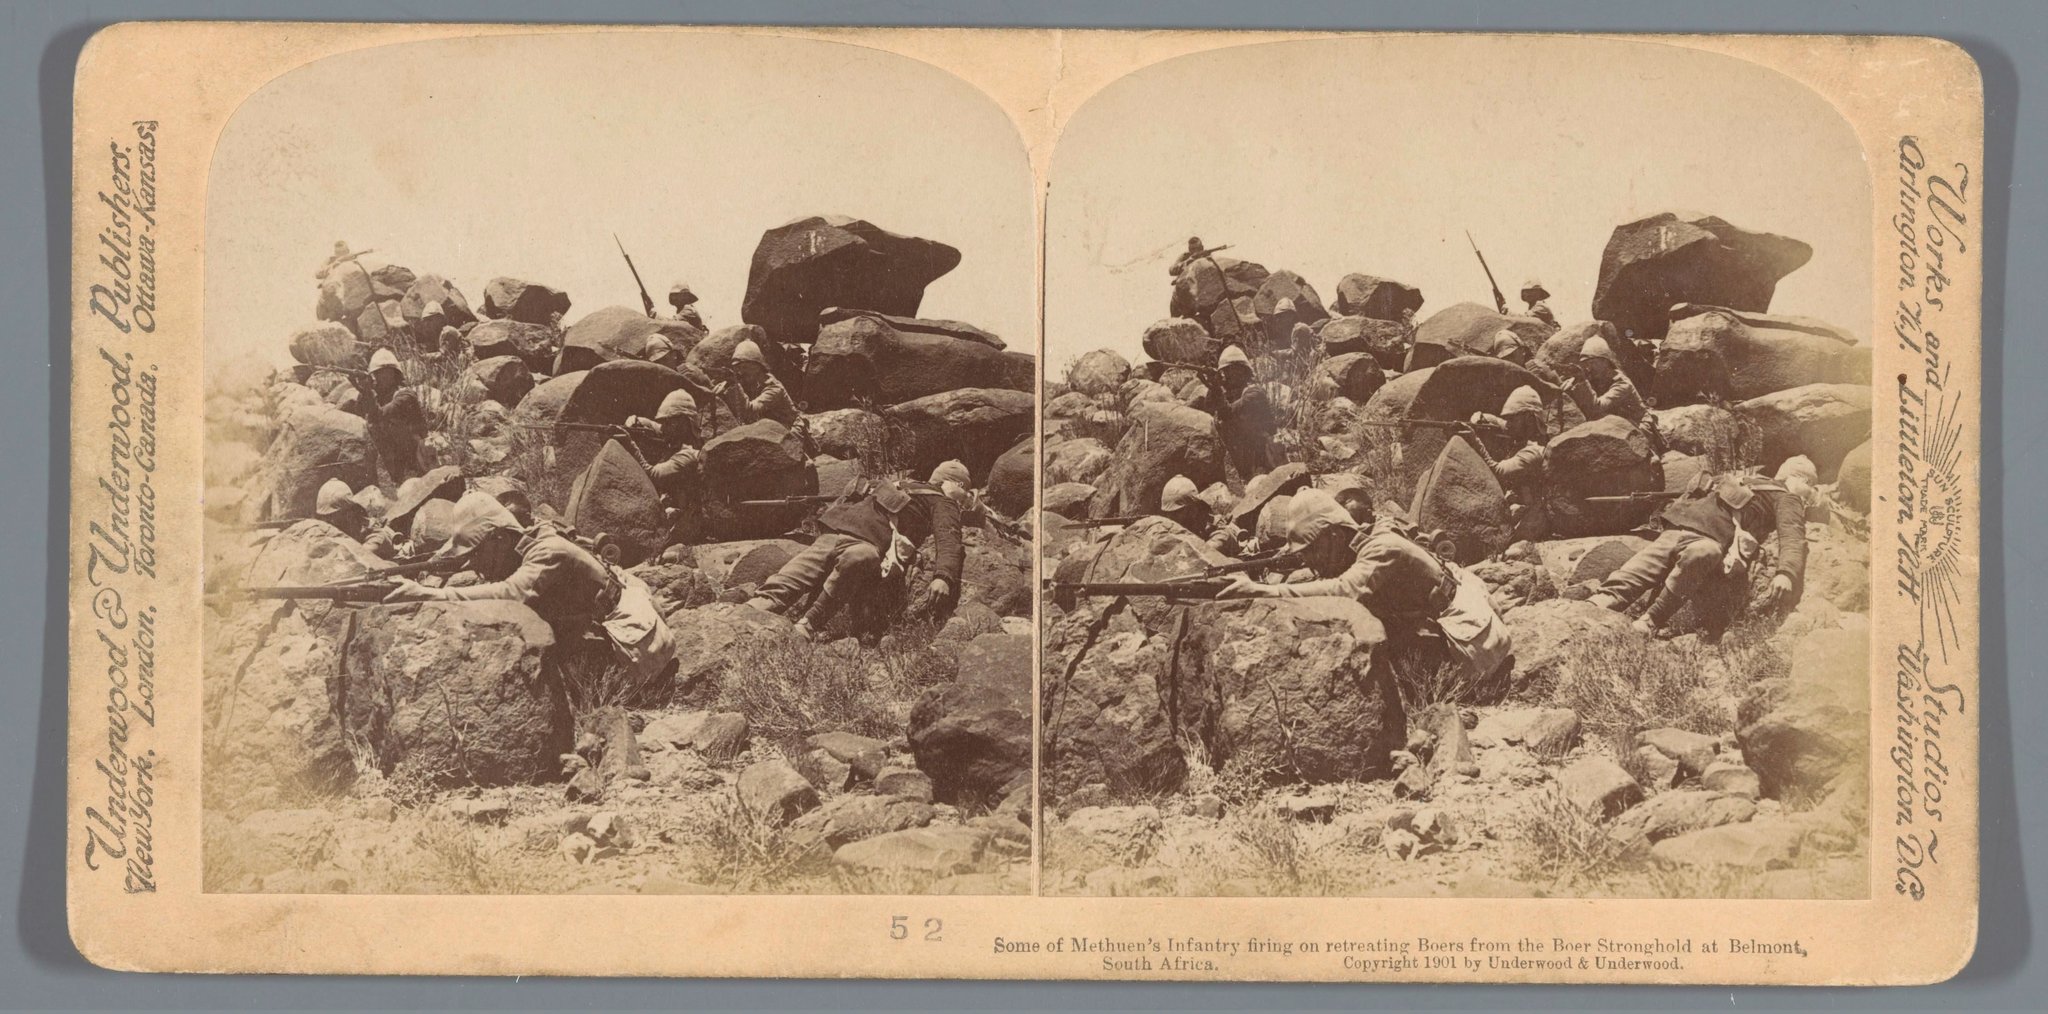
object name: stereograph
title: Some of Methuen's Infantry firing on retreating Boers, from the Boer Stronghold at Belmont, S.A.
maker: Anonymous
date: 1901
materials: cardboard, paper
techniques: albumen print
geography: new york city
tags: attack ~ siege, rock-formations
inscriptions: number: ‘52’, inscription, inscription: ‘Works and Studios ~/ Arlington, N.J. Littleton, N.H. Washington, D.C.’, copyright notice: ‘Copyright 1901 by Underwood & Underwood.’